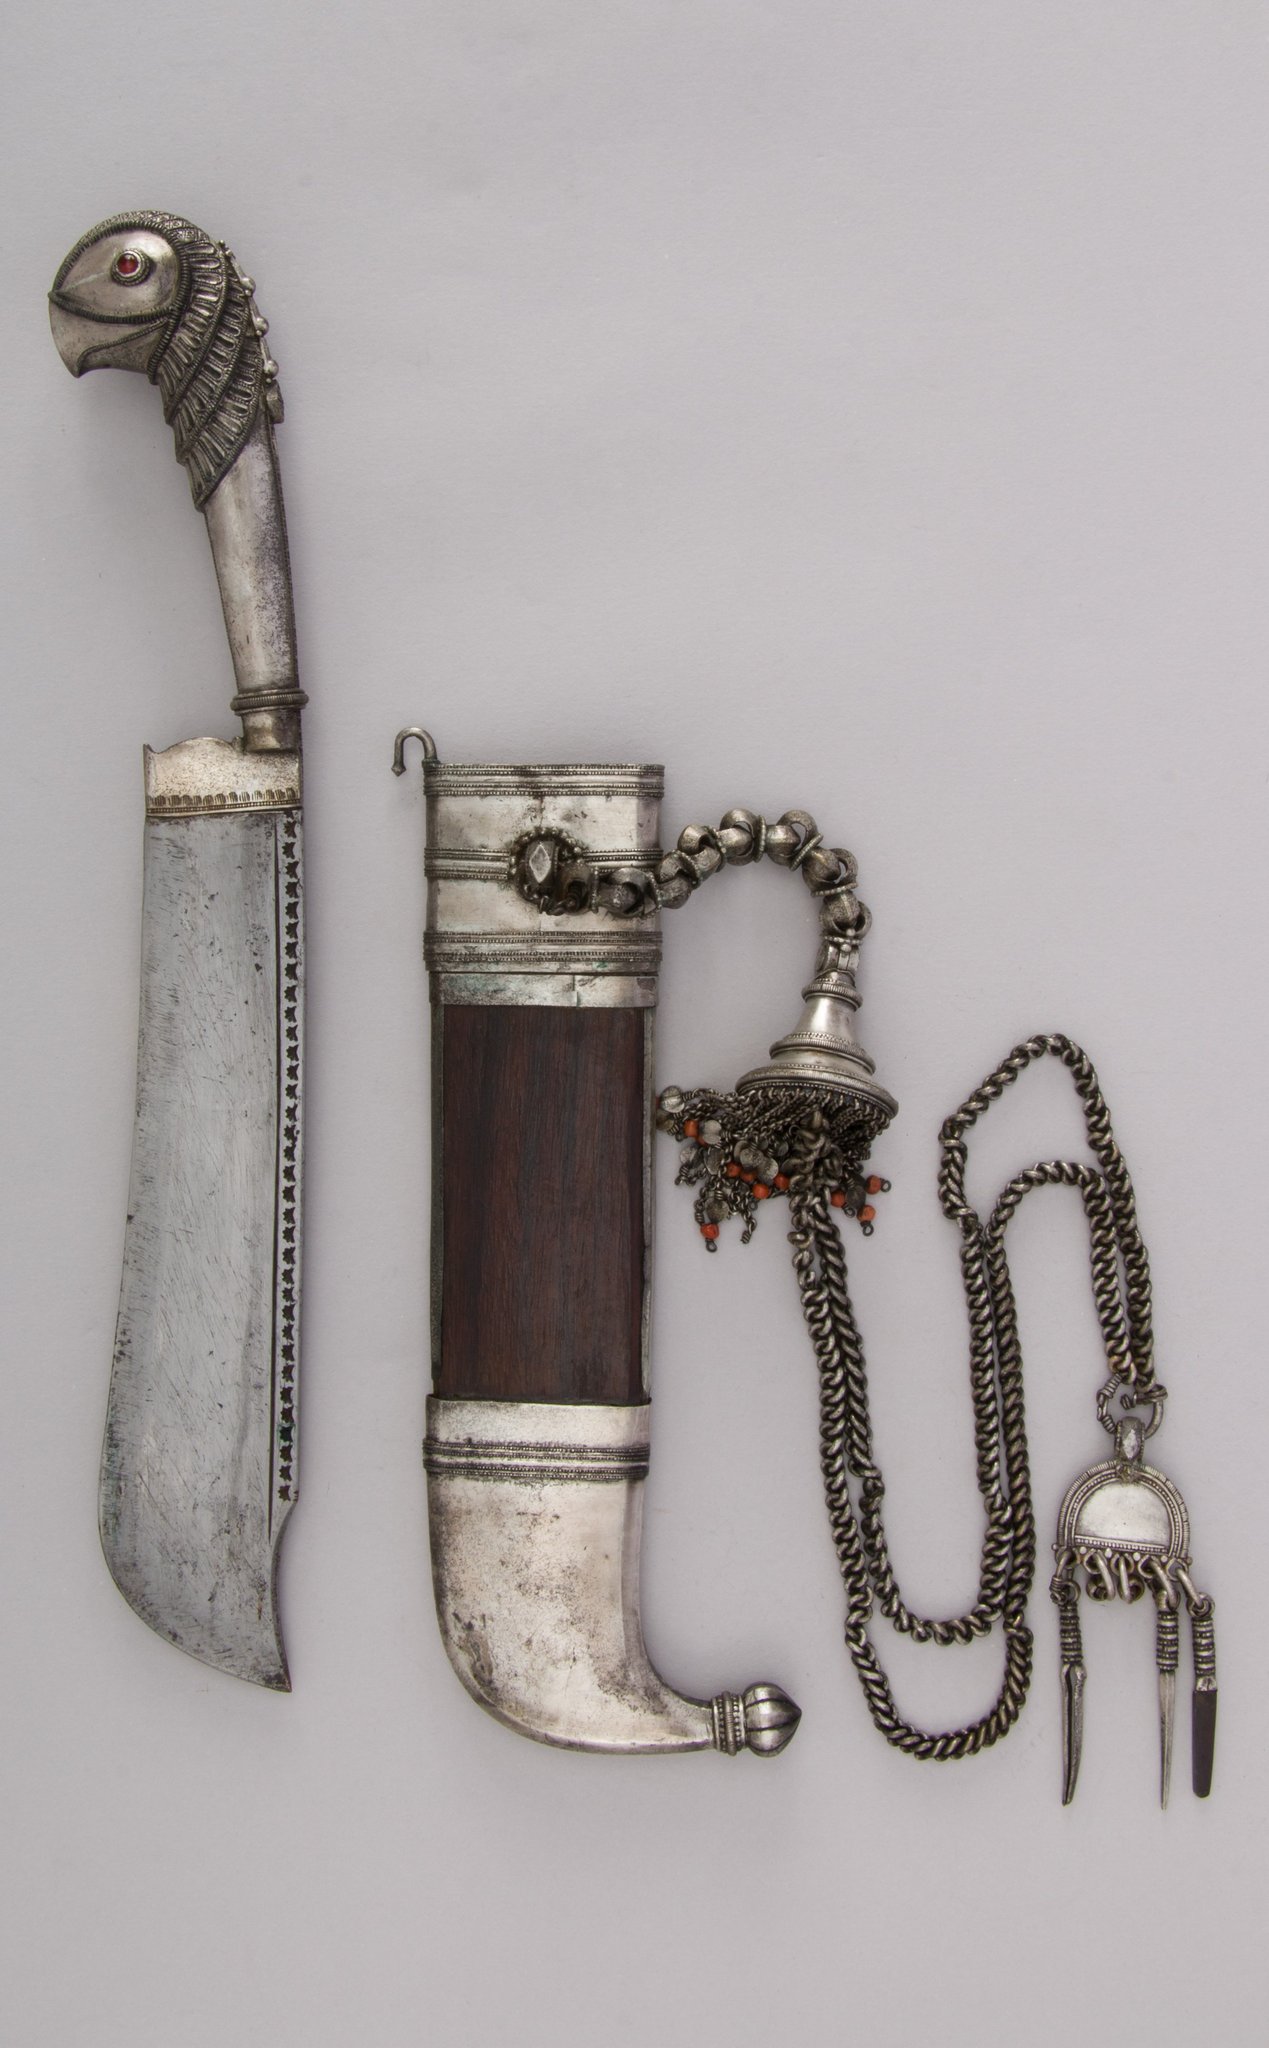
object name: dagger with sheath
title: Dagger (Pichangatti) with Sheath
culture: indian, kodagu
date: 1701-1800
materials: coral, gemstone, silver, steel, wood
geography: india